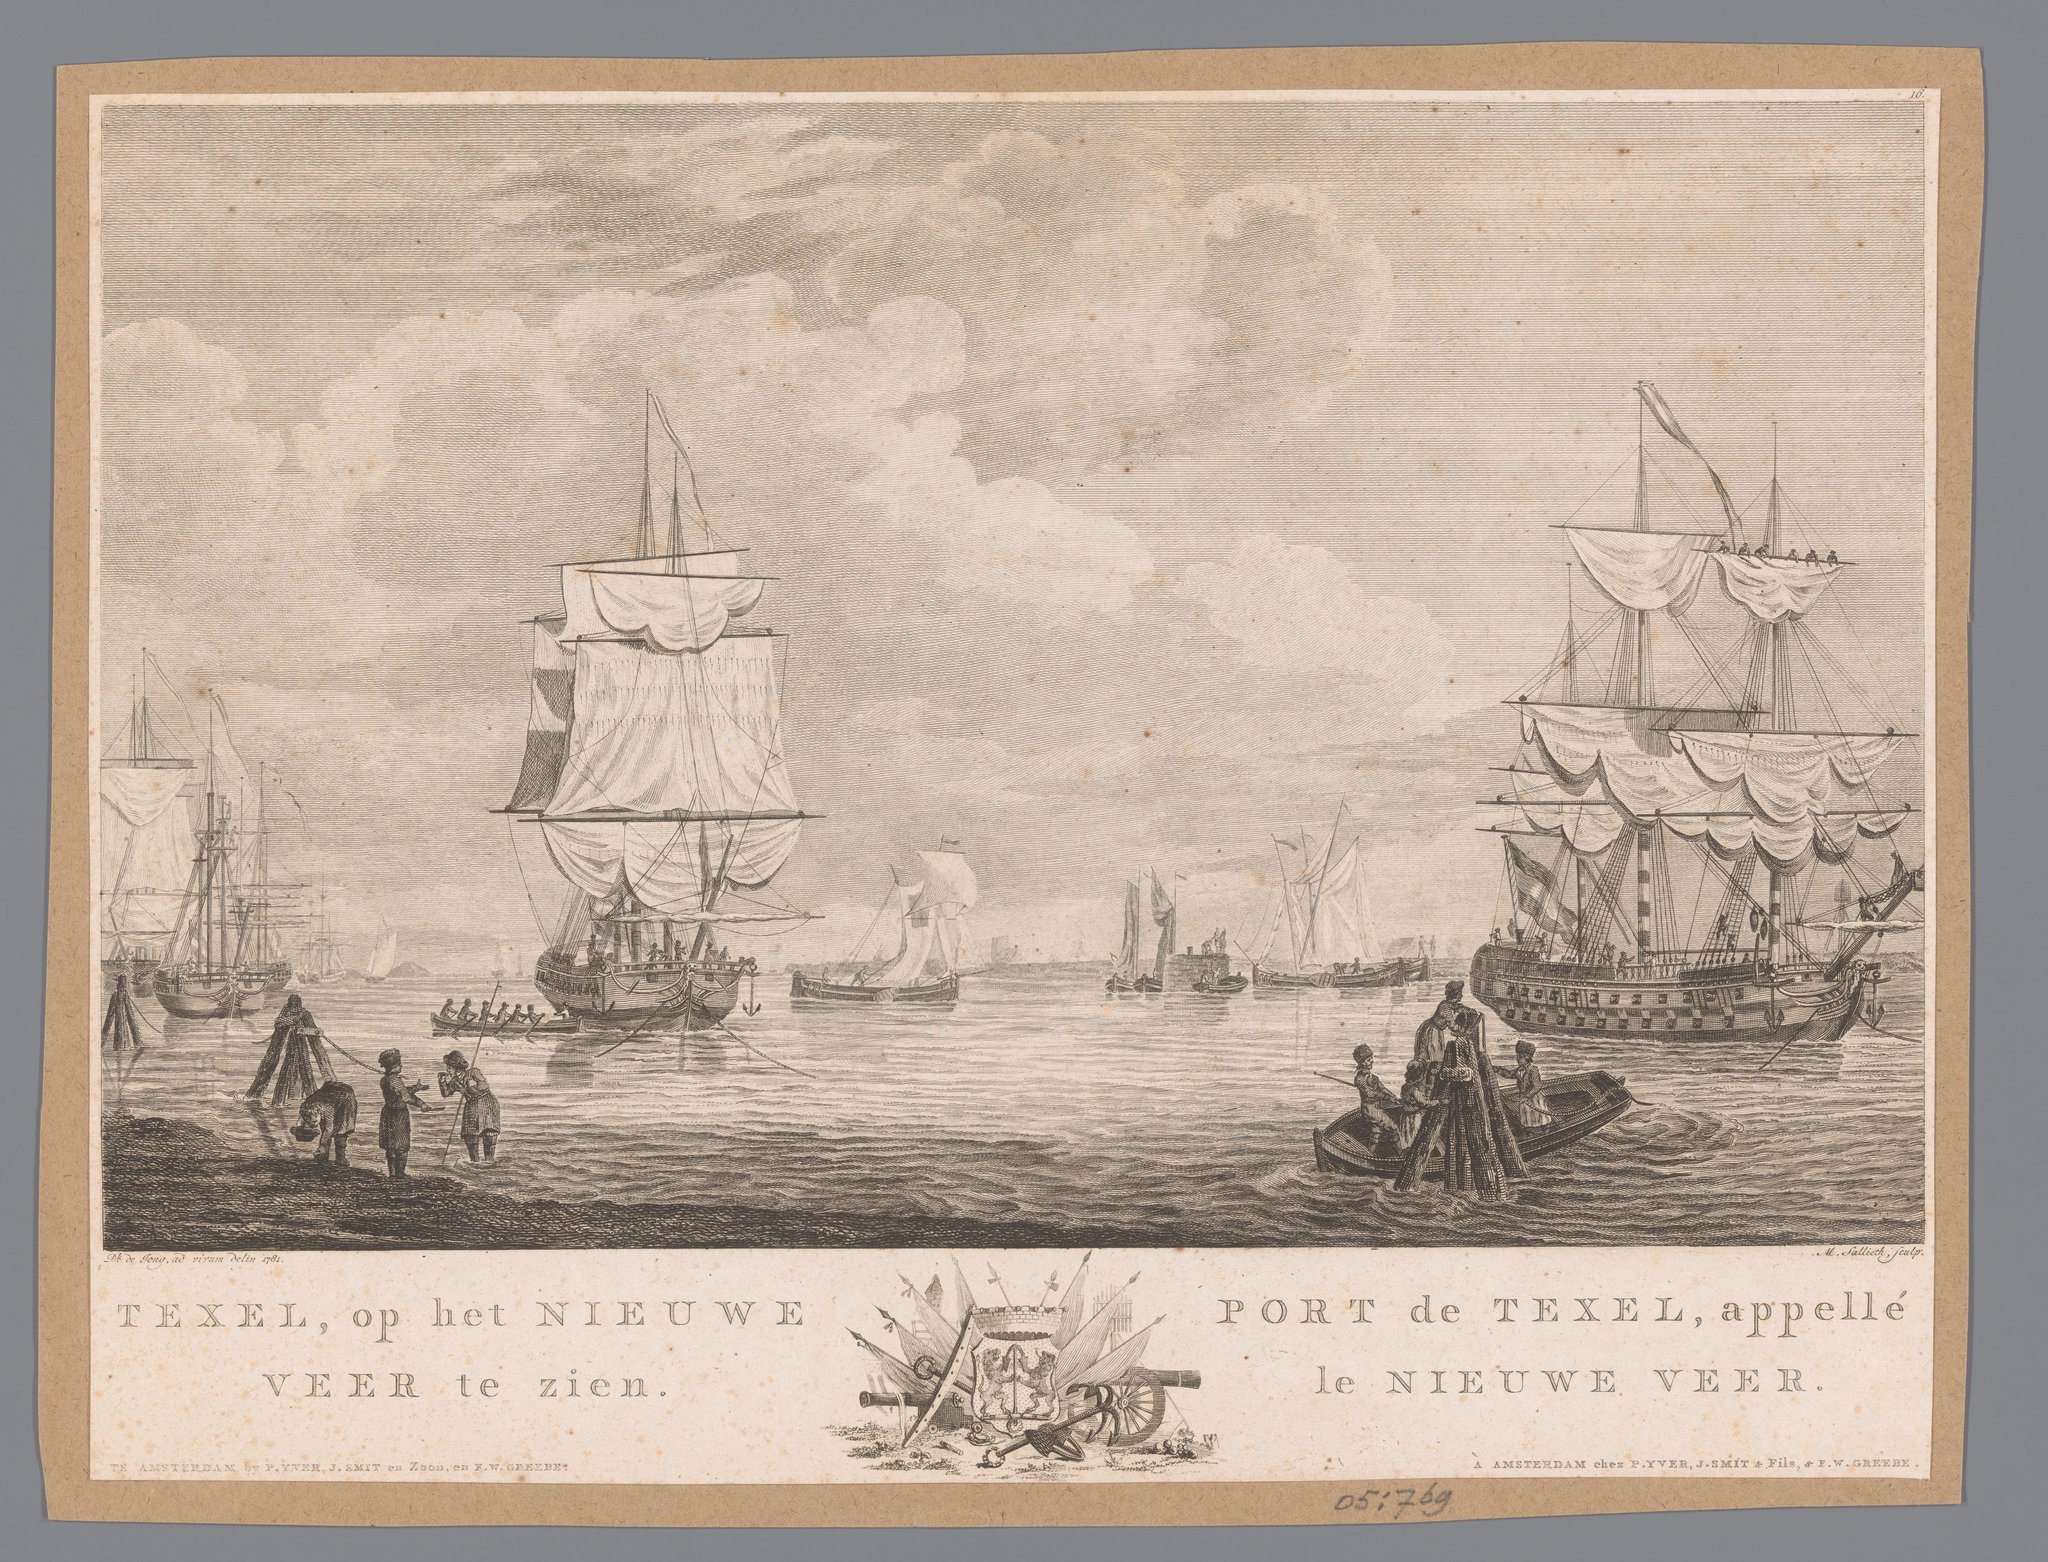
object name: print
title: Gezicht op Texel bij het Nieuwe Veer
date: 1781-1787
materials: paper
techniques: etching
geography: amsterdam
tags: coat of arms (as symbol of the state, etc.), coat of arms (as symbol of the state, etc.) (+ city; municipal), ships (in general)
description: Latere staat ook gebruikt in: Aa, Cornelis van der. Atlas van de zeehavens der Bataafsche Republiek. Met derzelver beschrijvingen in XXXI kunstplaaten / Atlas van de zeehavens der Bataafsche Republiek, die van Batavia en Onrust. Mitsgaders de afbeeldingen van de haringvisscherij en de walvischvangst […]. Amsterdam: Evert Maaskamp, 1805.